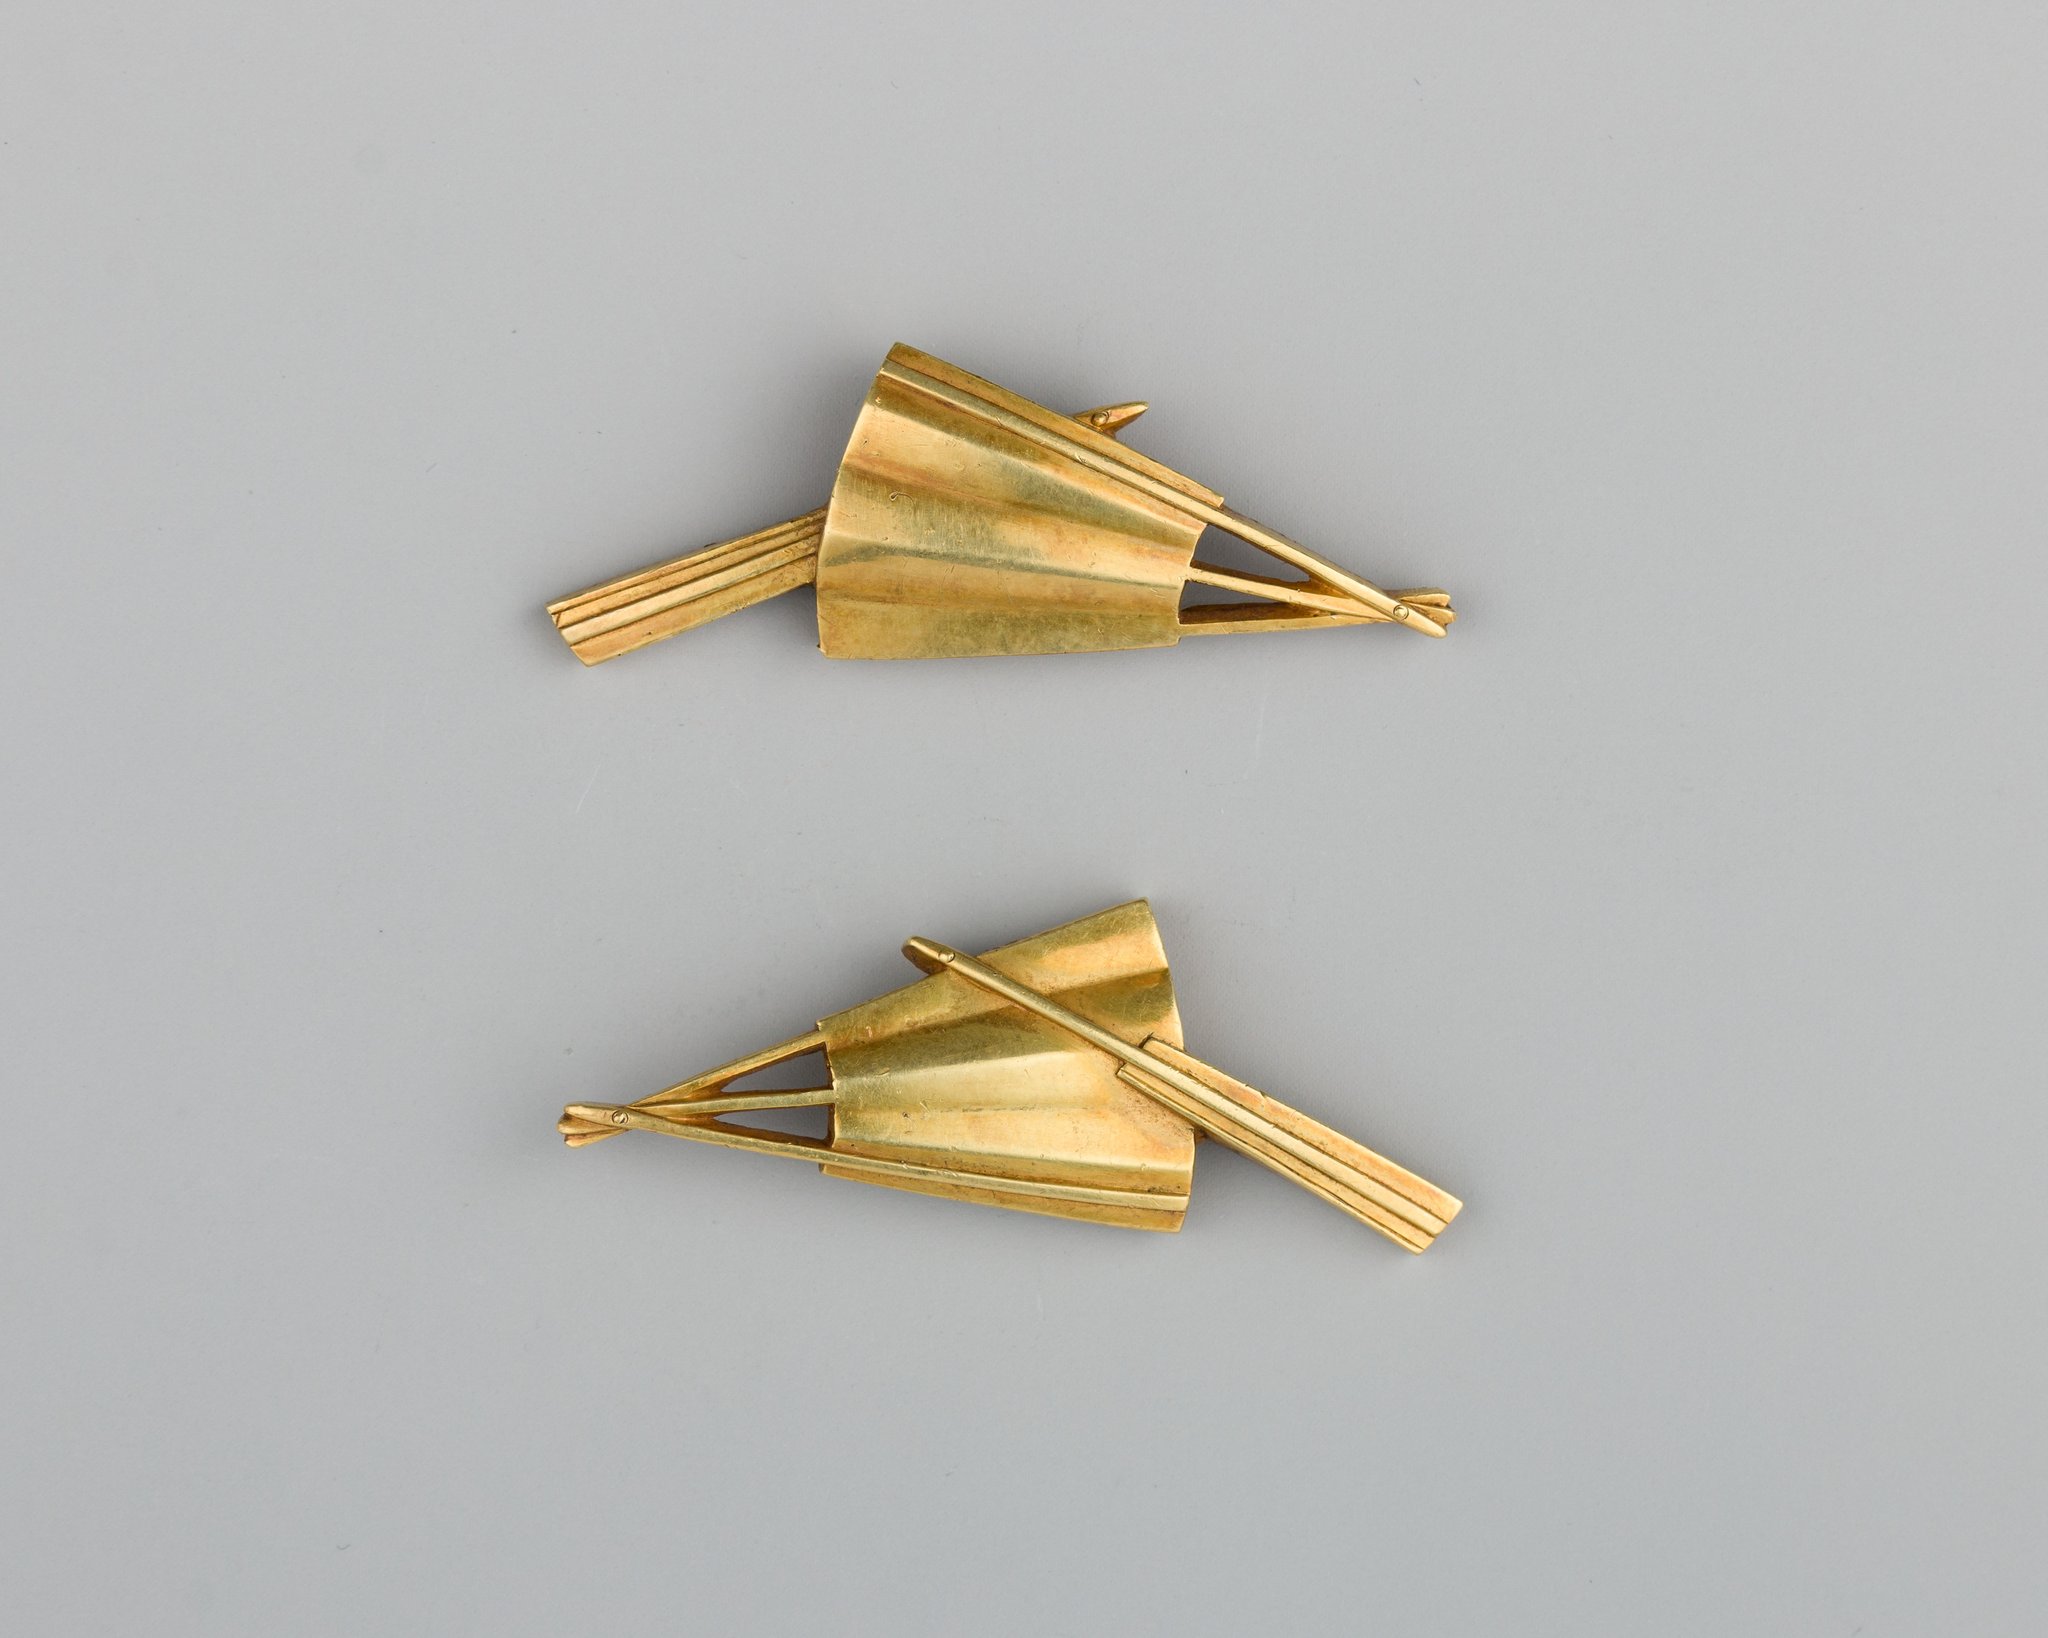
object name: pair of sword grip ornament menuki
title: Pair of Sword-Grip Ornaments (Menuki)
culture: japanese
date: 1701-1800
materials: gold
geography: japan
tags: fans